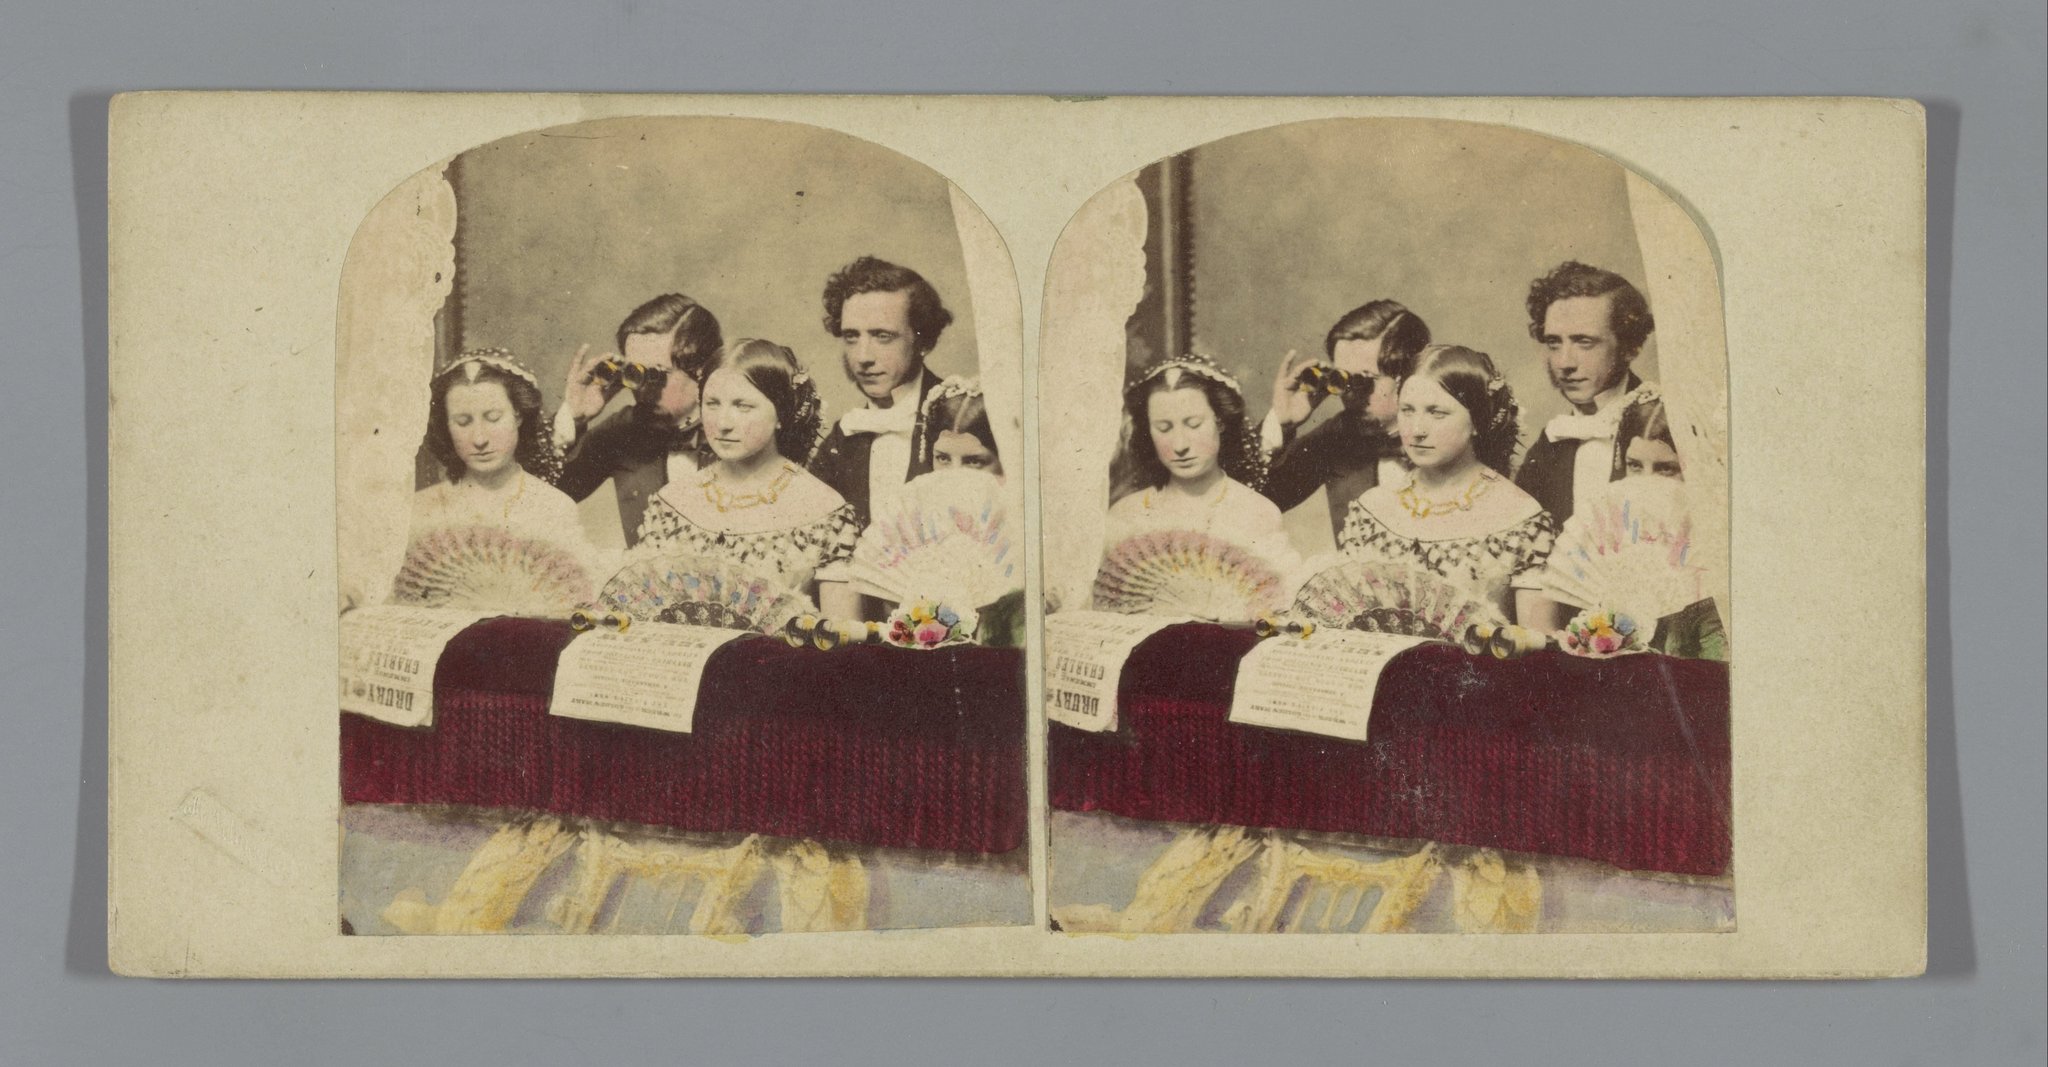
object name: stereograph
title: Tafereel in een theater: drie vrouwen en twee mannen in een loge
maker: alfred silvester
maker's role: fotograaf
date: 1850-1864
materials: cardboard, paper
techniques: albumen print, hand coloring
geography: london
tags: boxes, loges ~ theatre, etc.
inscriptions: number: ‘150’